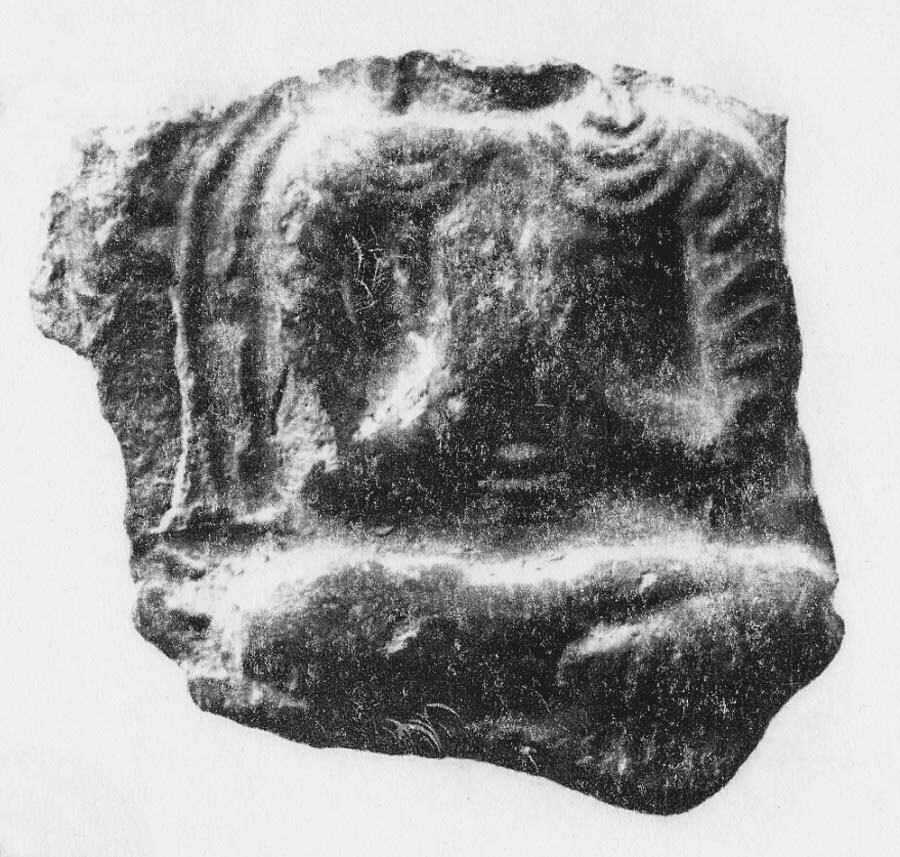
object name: fragment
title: Seated Headless Buddha (Study Collection)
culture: kashmiri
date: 701-800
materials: terracotta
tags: kashmir,buddhism,buddha